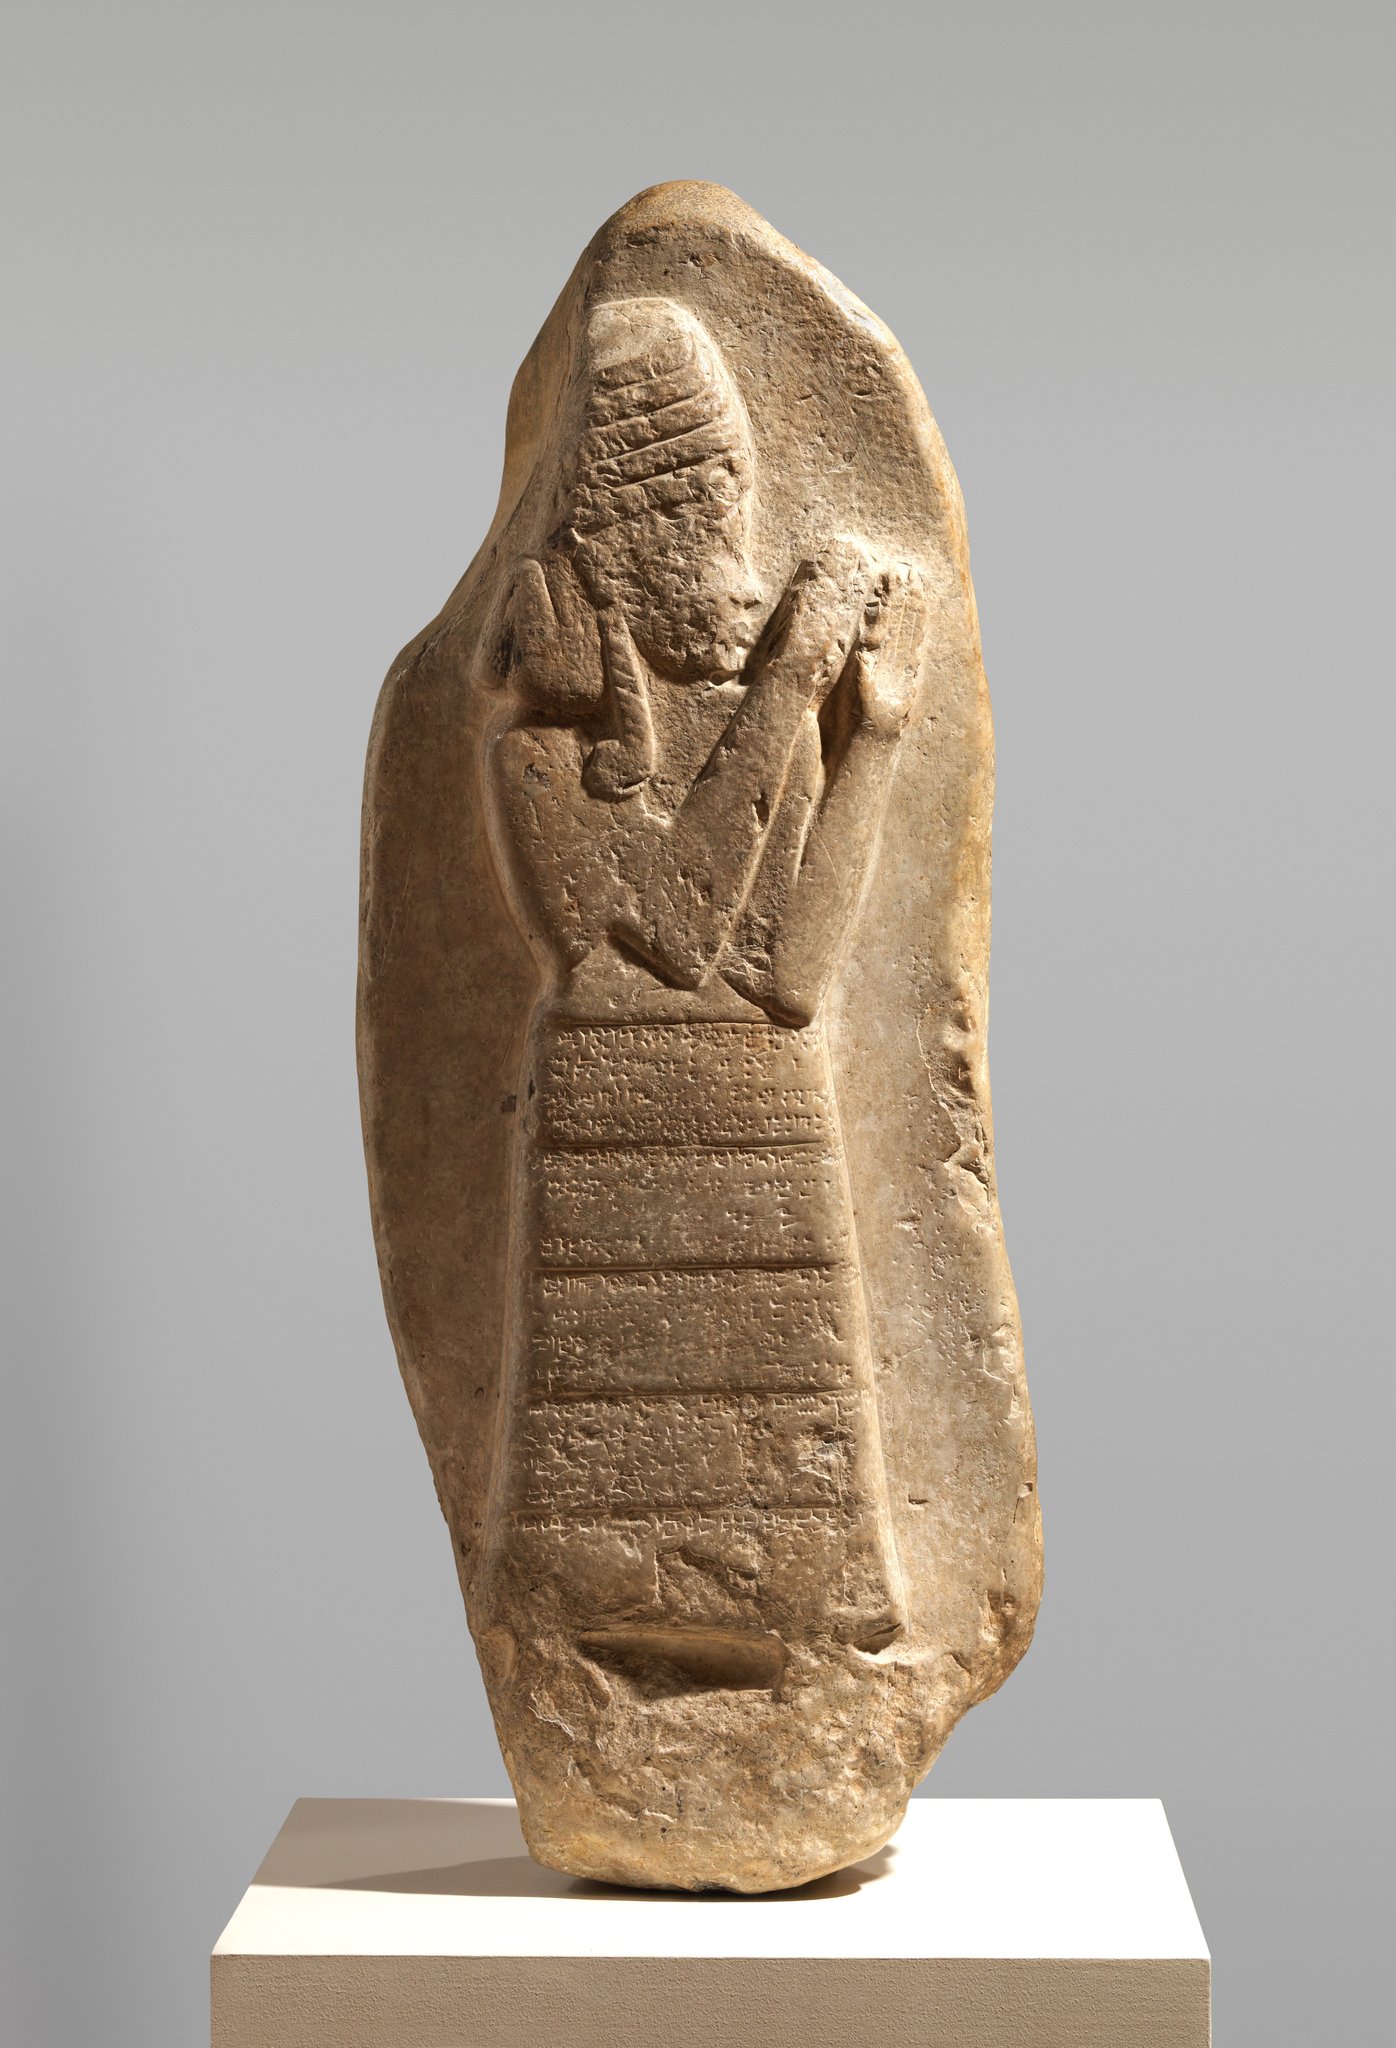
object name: relief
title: Stele of the protective goddess Lama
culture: kassite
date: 1307-1282 BCE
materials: alabaster, gypsum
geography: mesopotamia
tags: goddess